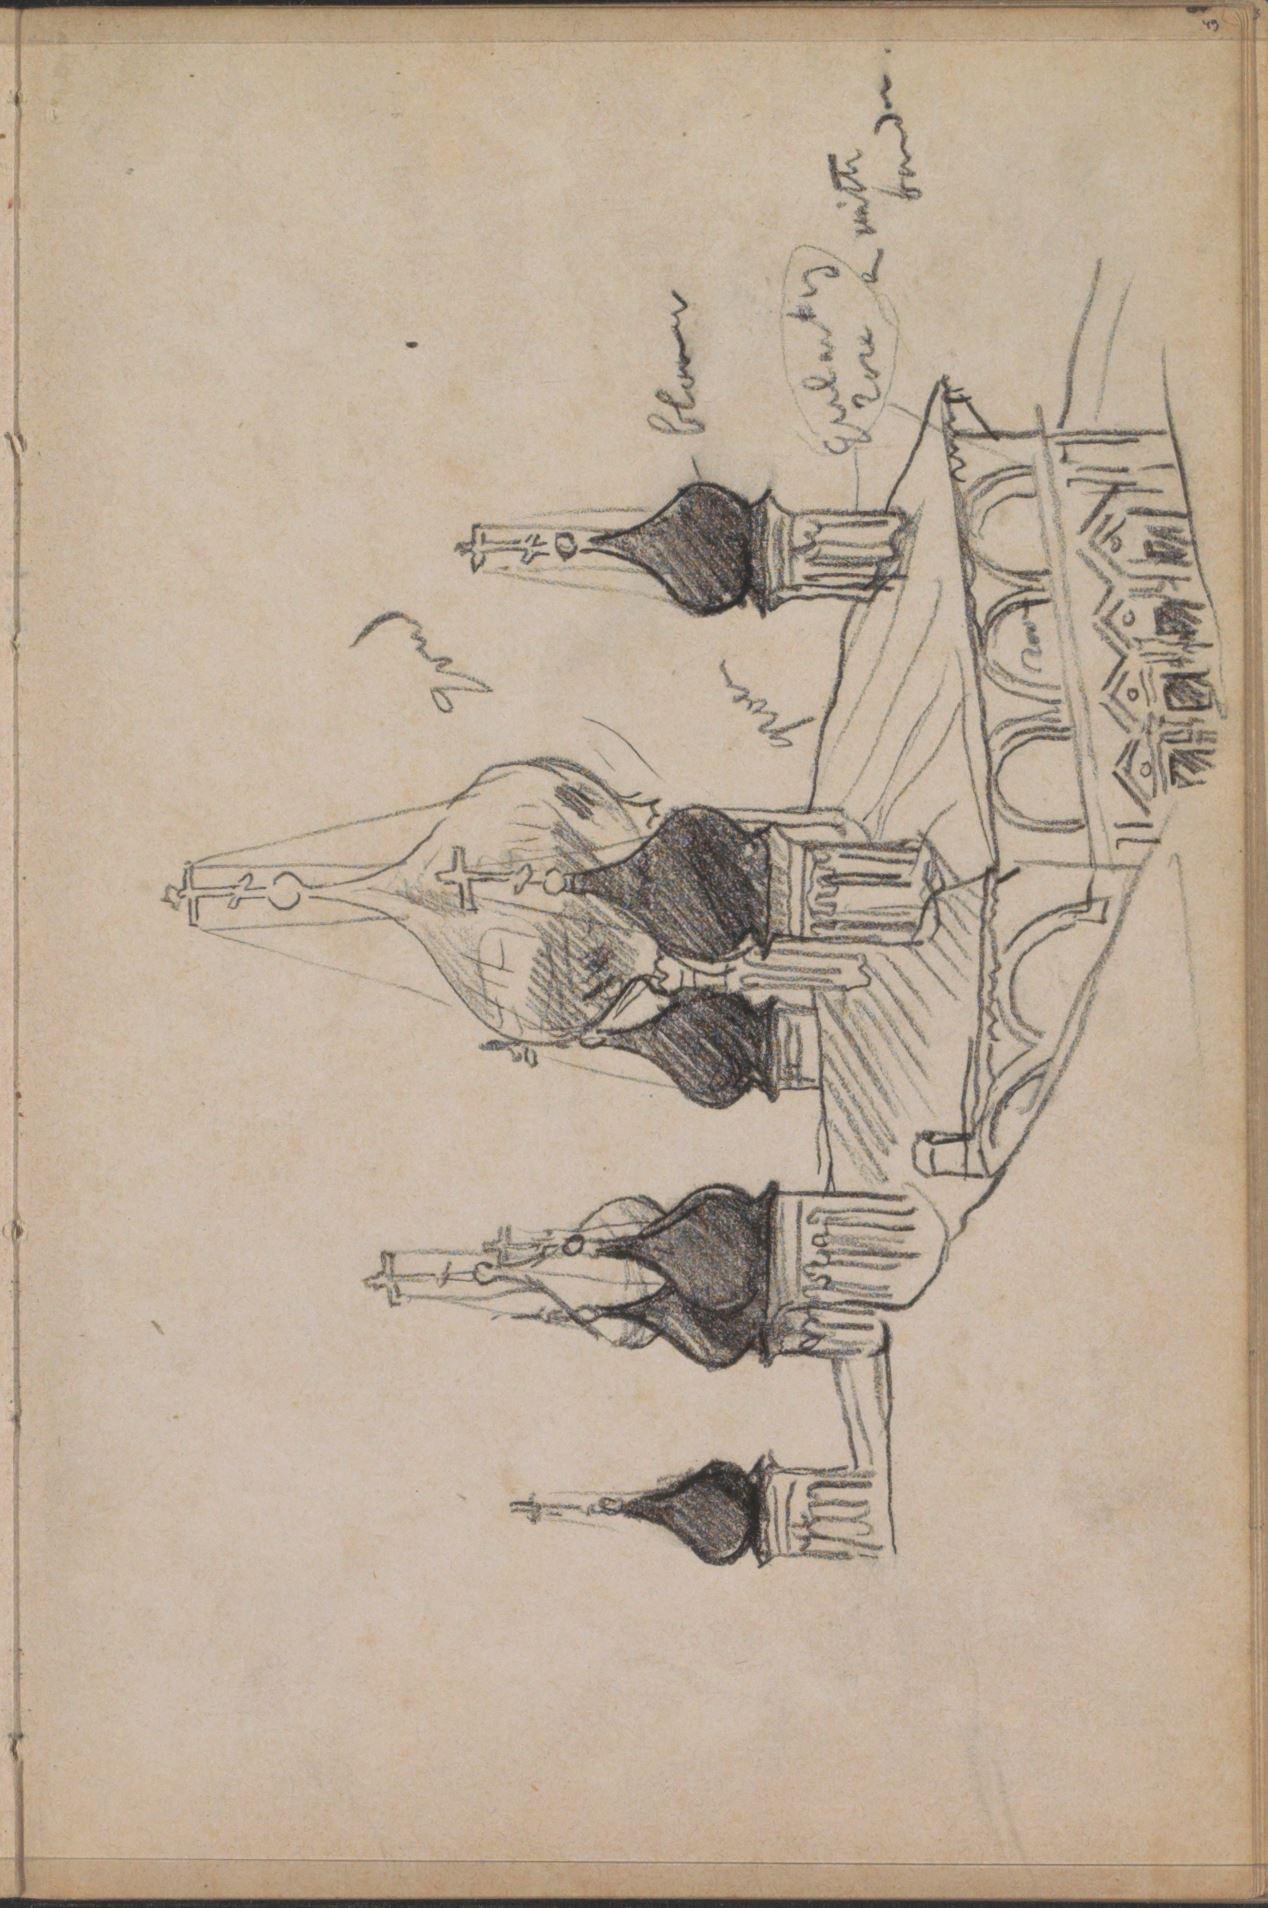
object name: sketchbook leaf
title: Koepels van een kathedraal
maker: marius bauer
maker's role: draughtsman, print maker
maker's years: 1867-1932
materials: chalk, paper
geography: moscow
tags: church (exterior), dome ~ architecture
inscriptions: kleurnotitie, handgeschreven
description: Pagina 49 uit een schetsboek met 54 bladen.